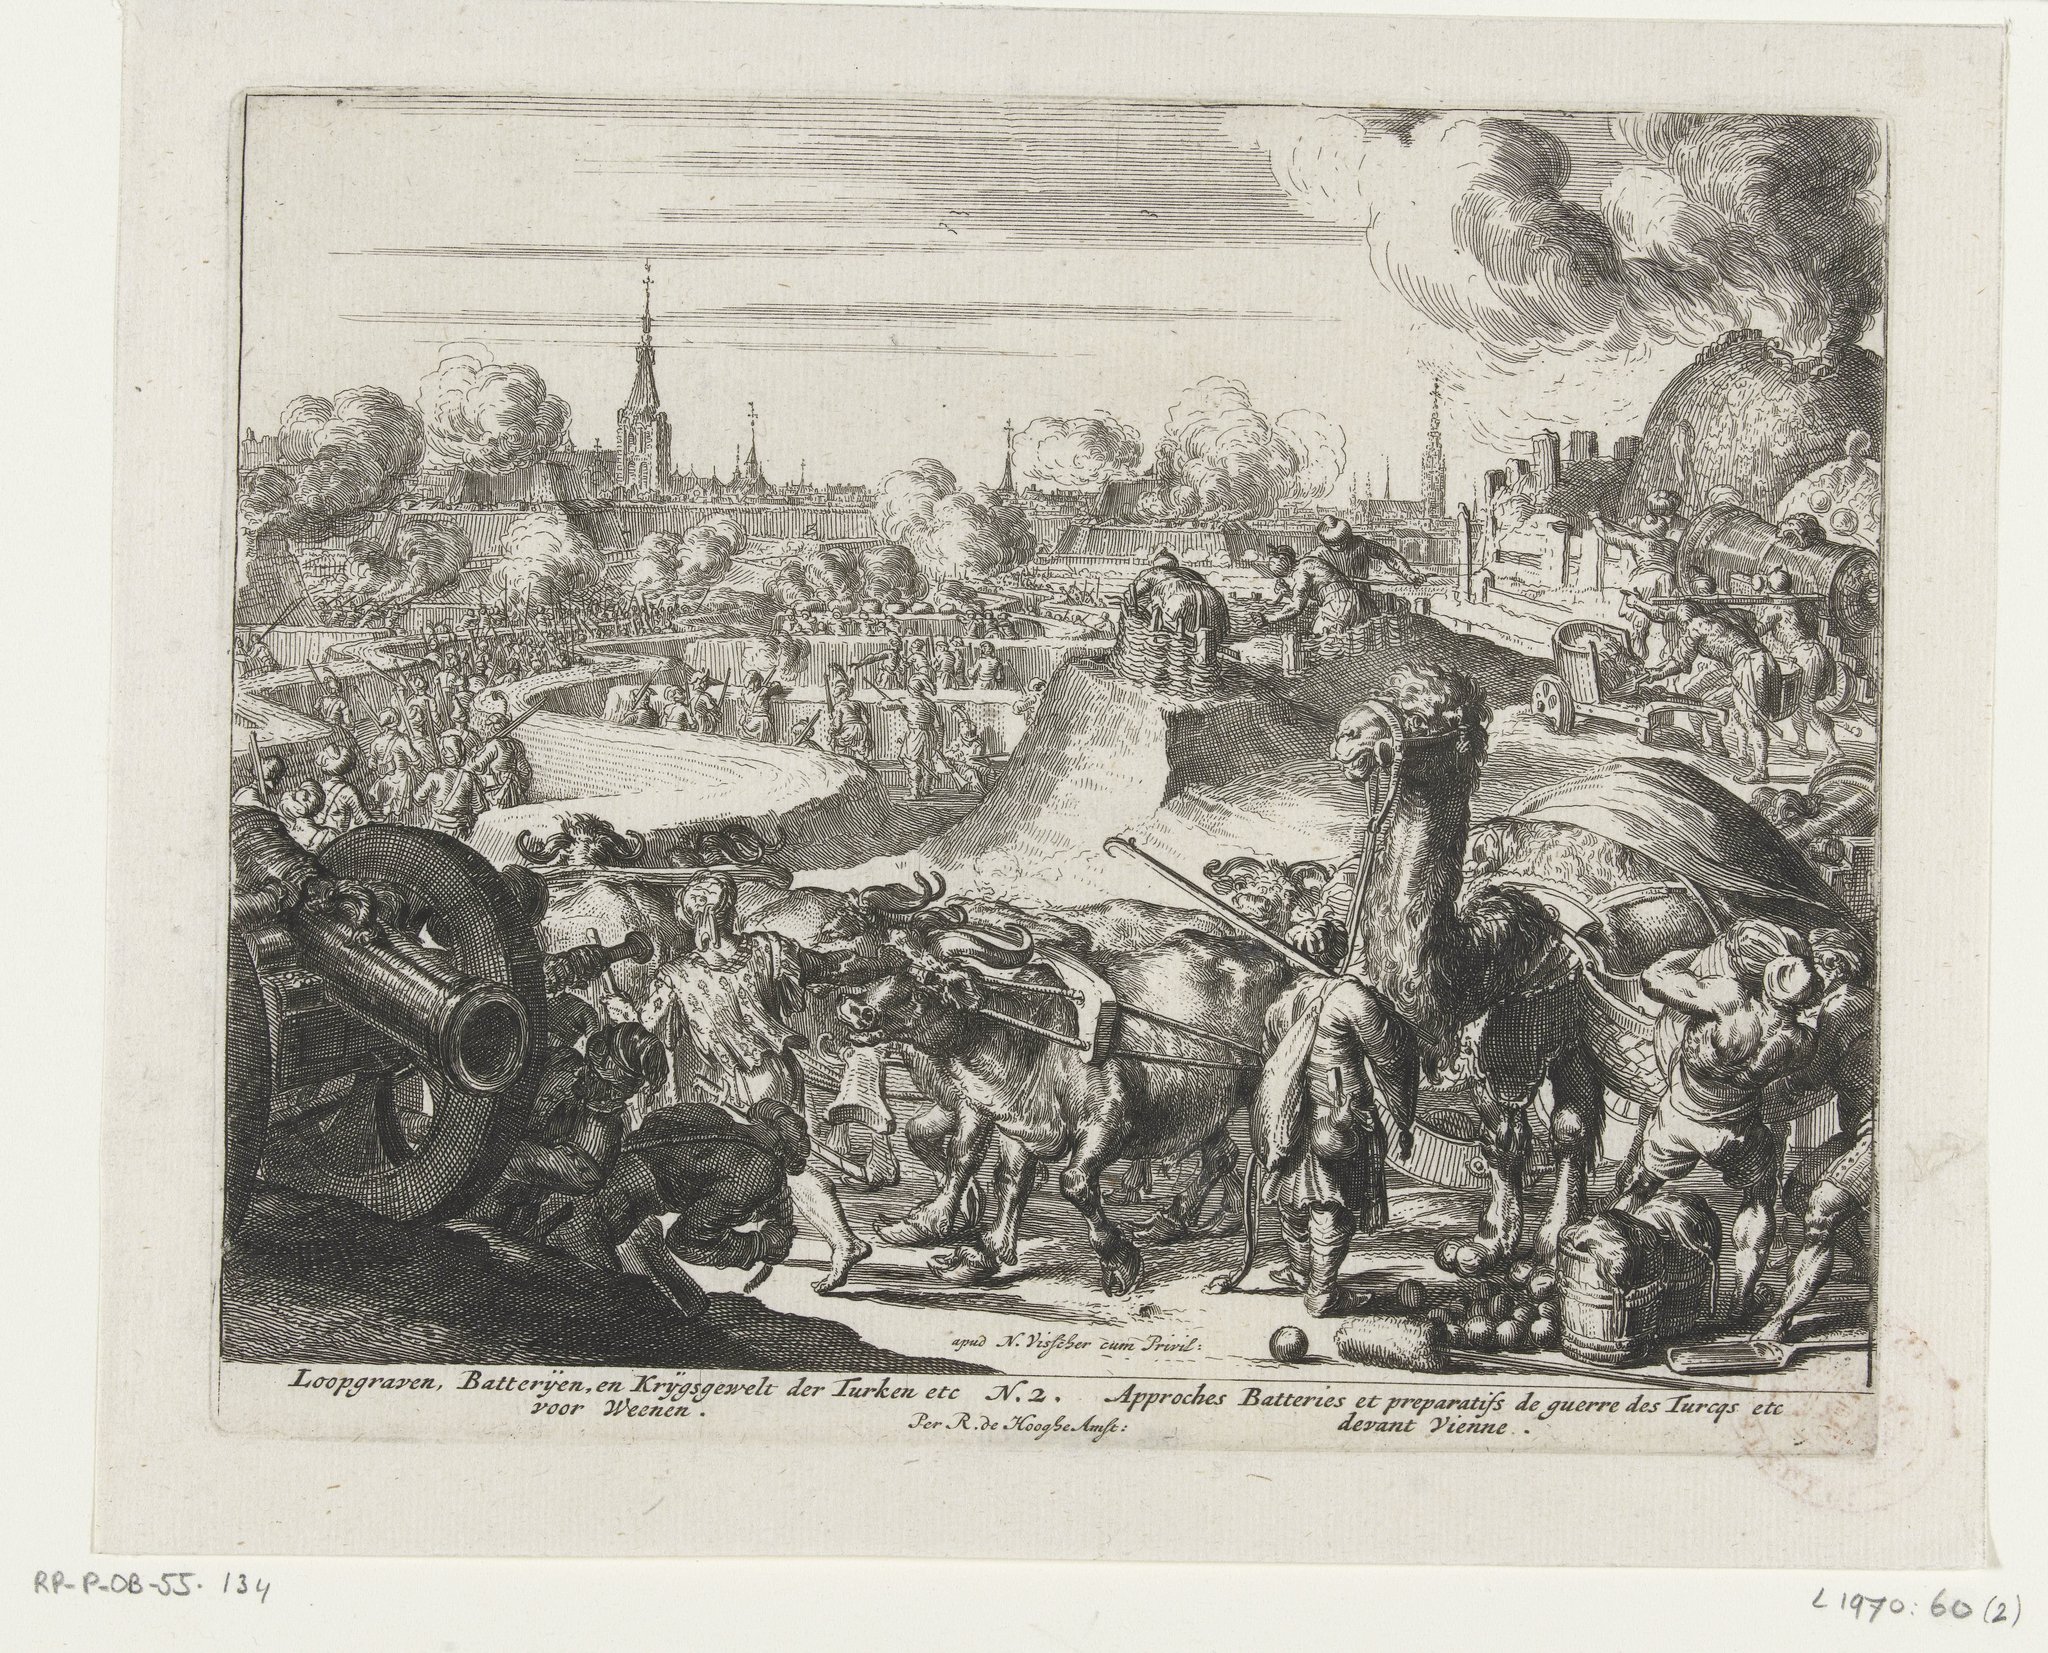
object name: print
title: Loopgraven, Batterijen, en Krijgsgewelt der Turken etc. voor Weenen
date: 1684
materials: paper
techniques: engraving, etching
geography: amsterdam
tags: jan iii sobieski (koning van polen), vienna, leopold i (keizer van duitsland), siege, position war, trenches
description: Illustratie voor Johann van Ghelen, Relation succinte et veritable de tout ce qui s'est passé pendant le siege de Vienne, residence de Sa Majesté Imperiale, assiegée par les Turcs depuis le 14. juillet jusqu'au 12. de septembre 1683., Bruxelles: Jean Leonard, 1684.